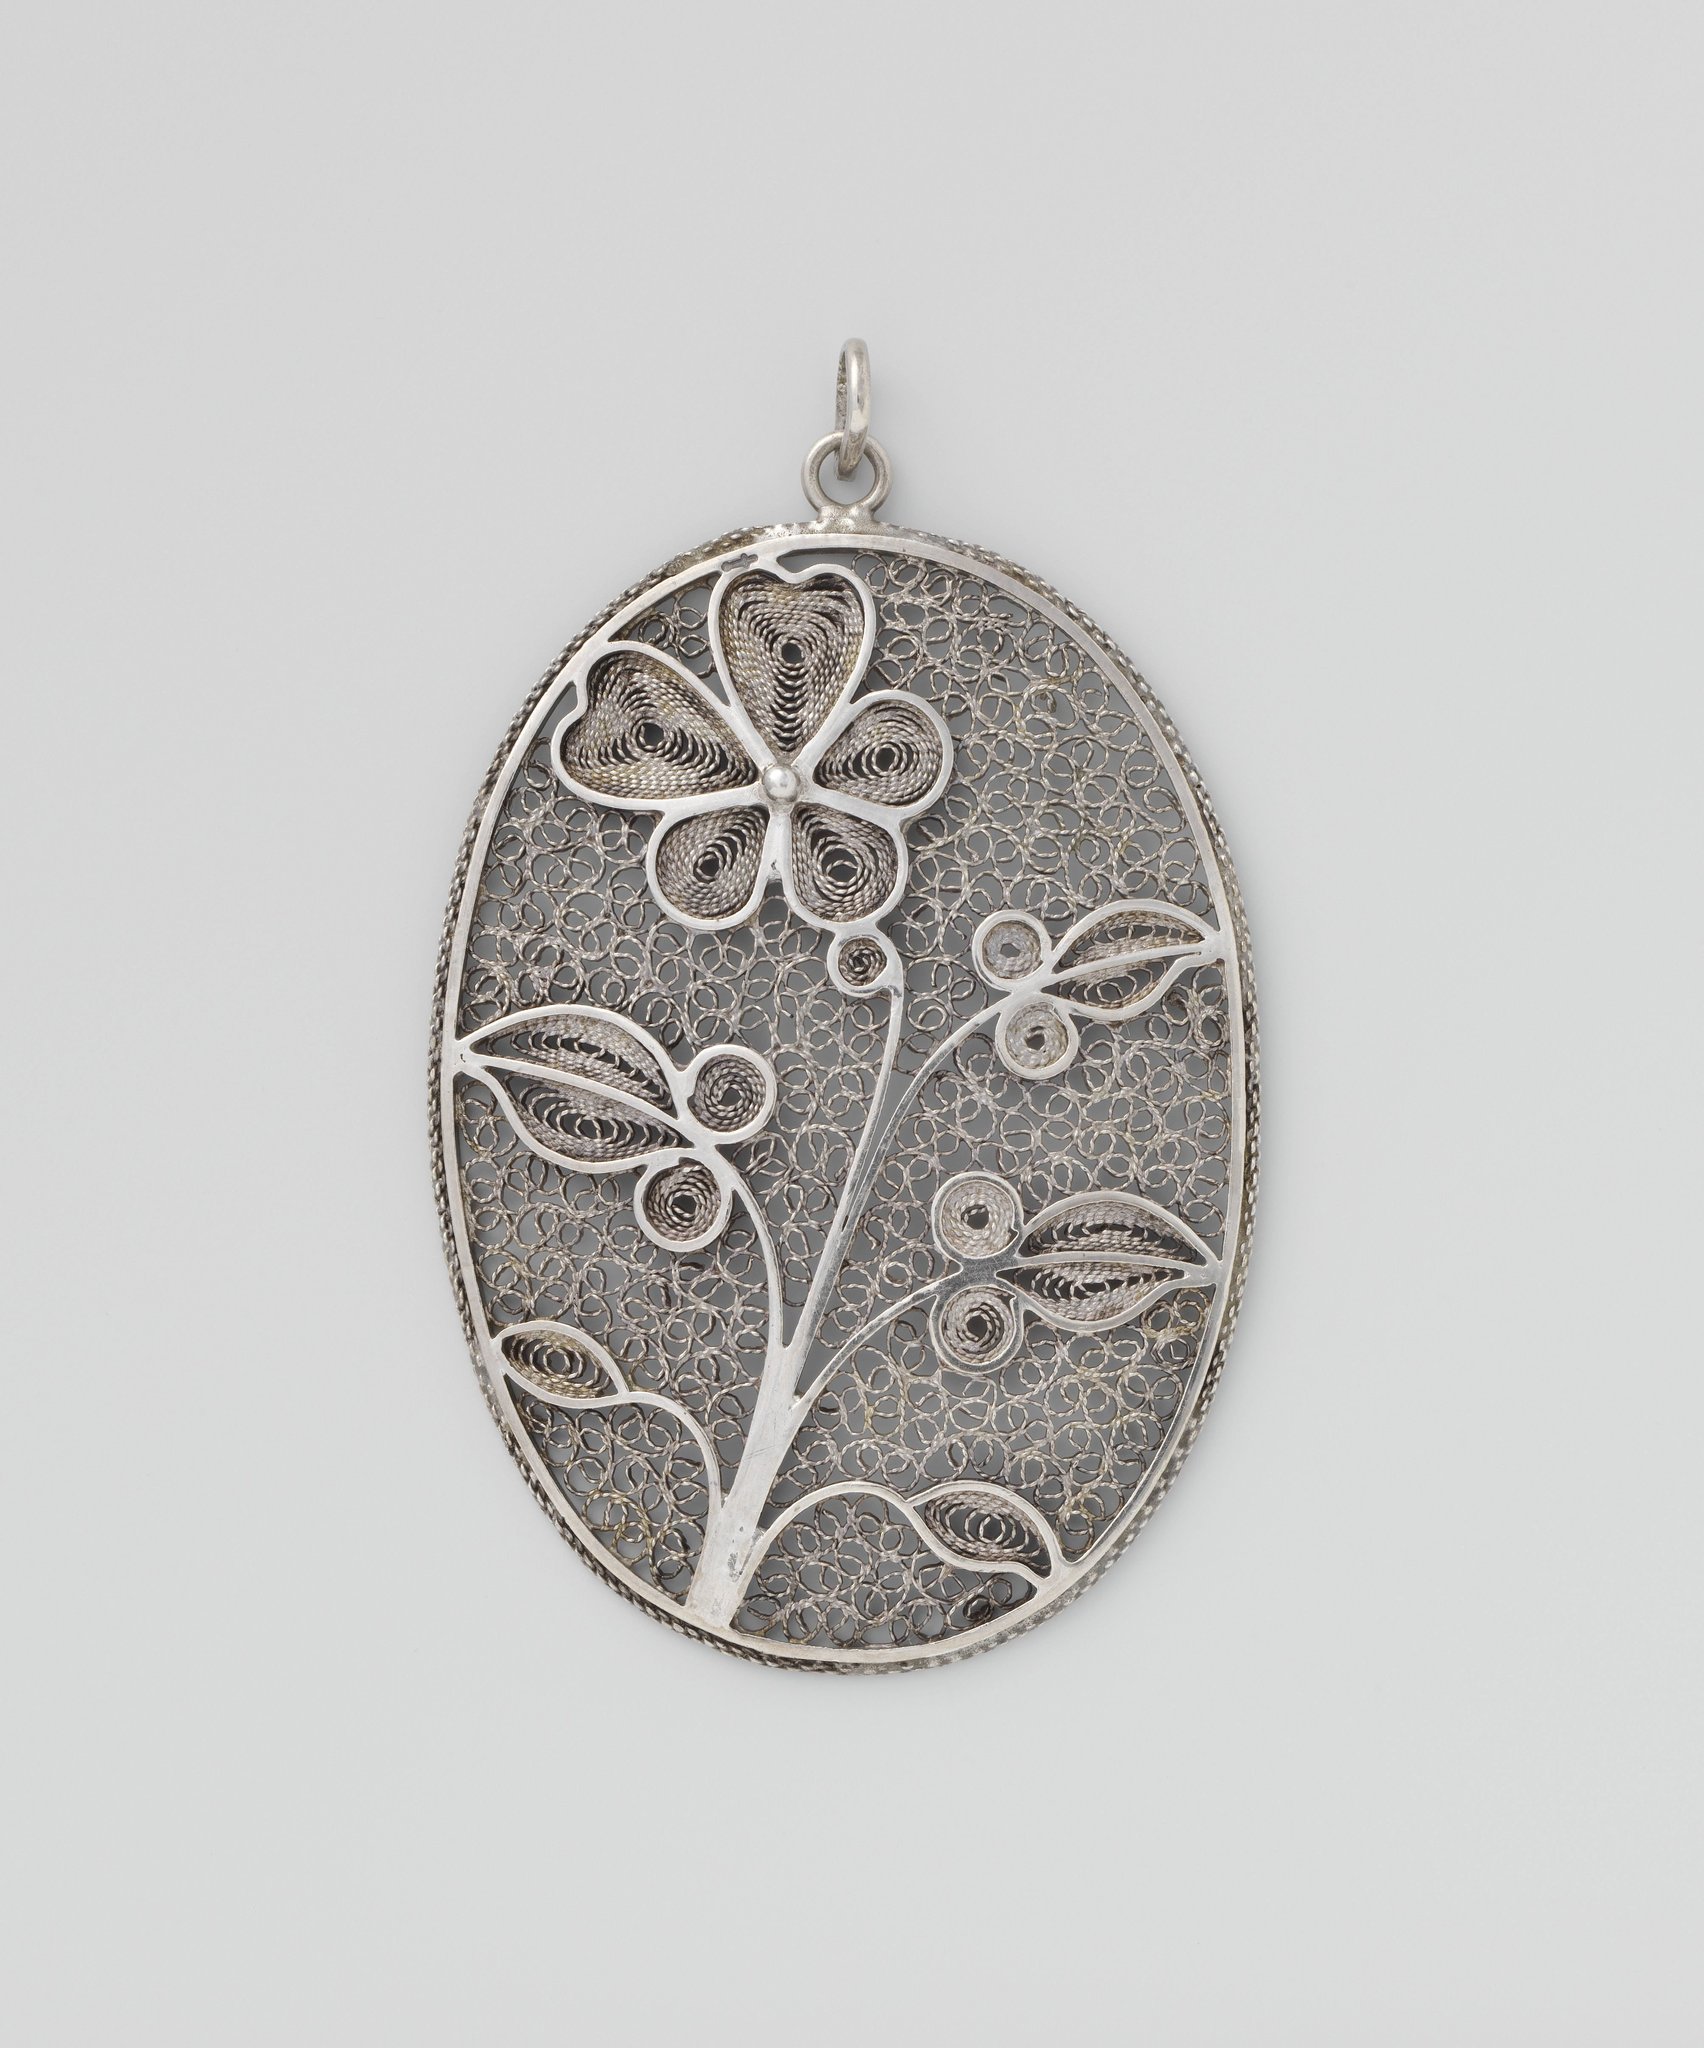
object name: pendant jewelry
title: Hanger met viooltje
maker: Anonymous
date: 1930-1940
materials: silver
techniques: filigree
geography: netherlands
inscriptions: alloy mark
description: Ovale hanger in filigrein van zilver met viooltje voorzien van een draadoog.